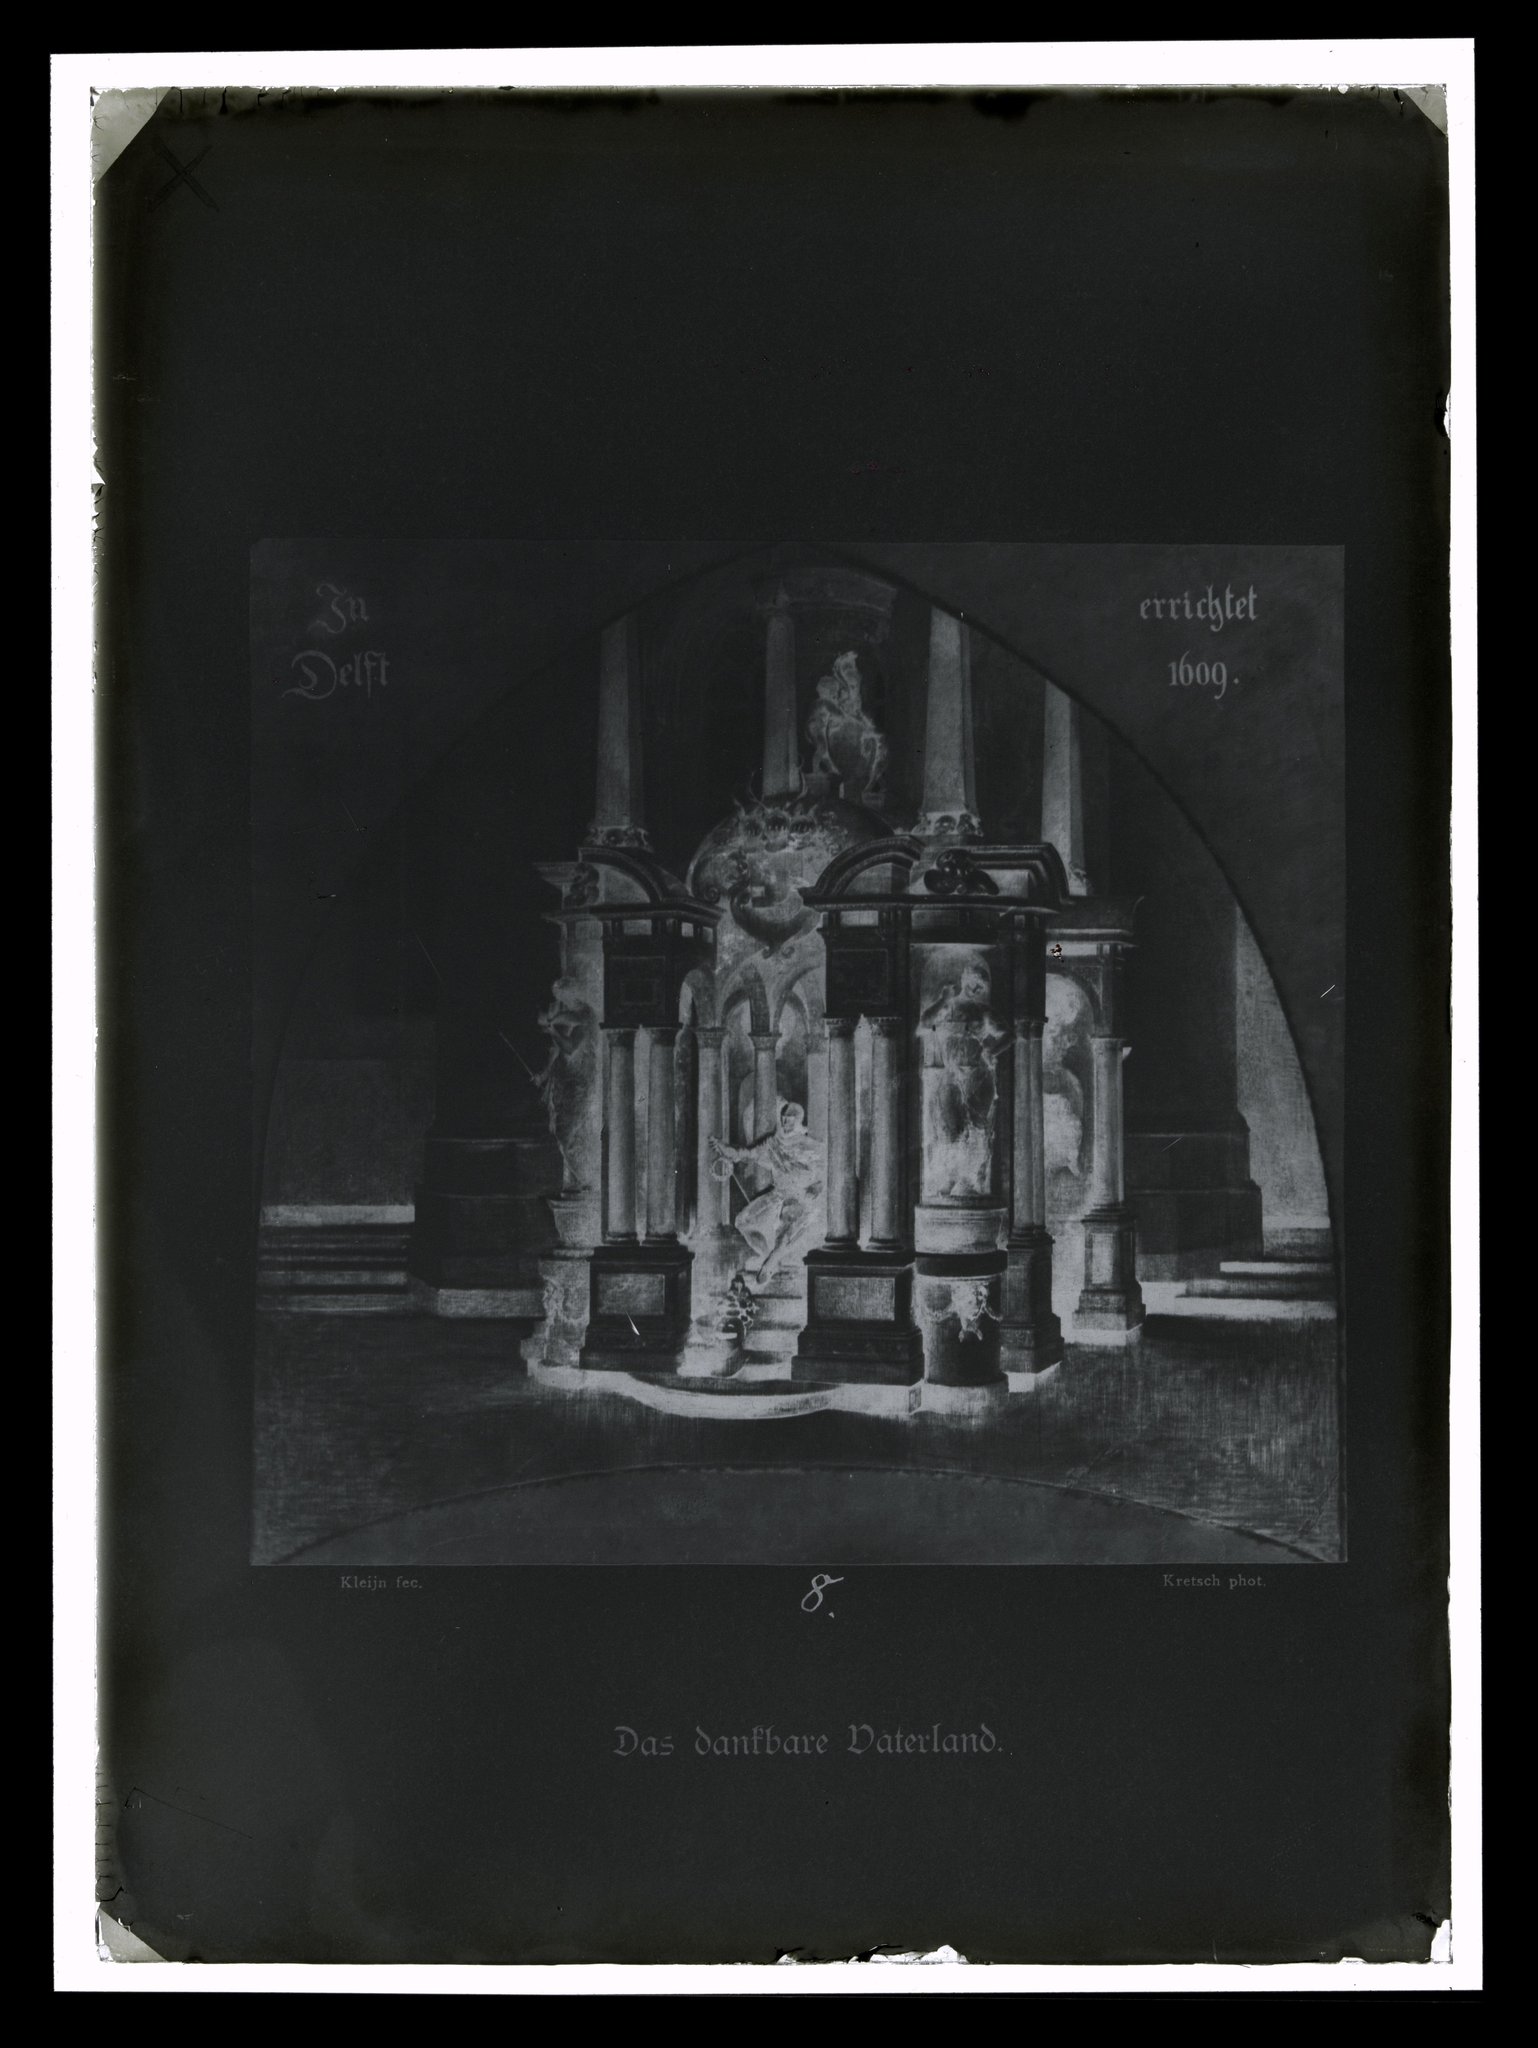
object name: reproduction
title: Fotoreproductie van een schilderij van het praalgraf van Willem van Oranje in de Nieuwe Kerk in Delft, door Laurens Lodewijk Kleijn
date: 1884-1900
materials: glass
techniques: collodion process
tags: delft, william i (prince of orange), grave, tomb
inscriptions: number: ‘8.’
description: Onderdeel van een groep glasnegatieven uit de nalatenschap van de schilder Laurens Lodewijk Kleijn, met stillevens, portretten, zelfportretten en kunstreproducties.